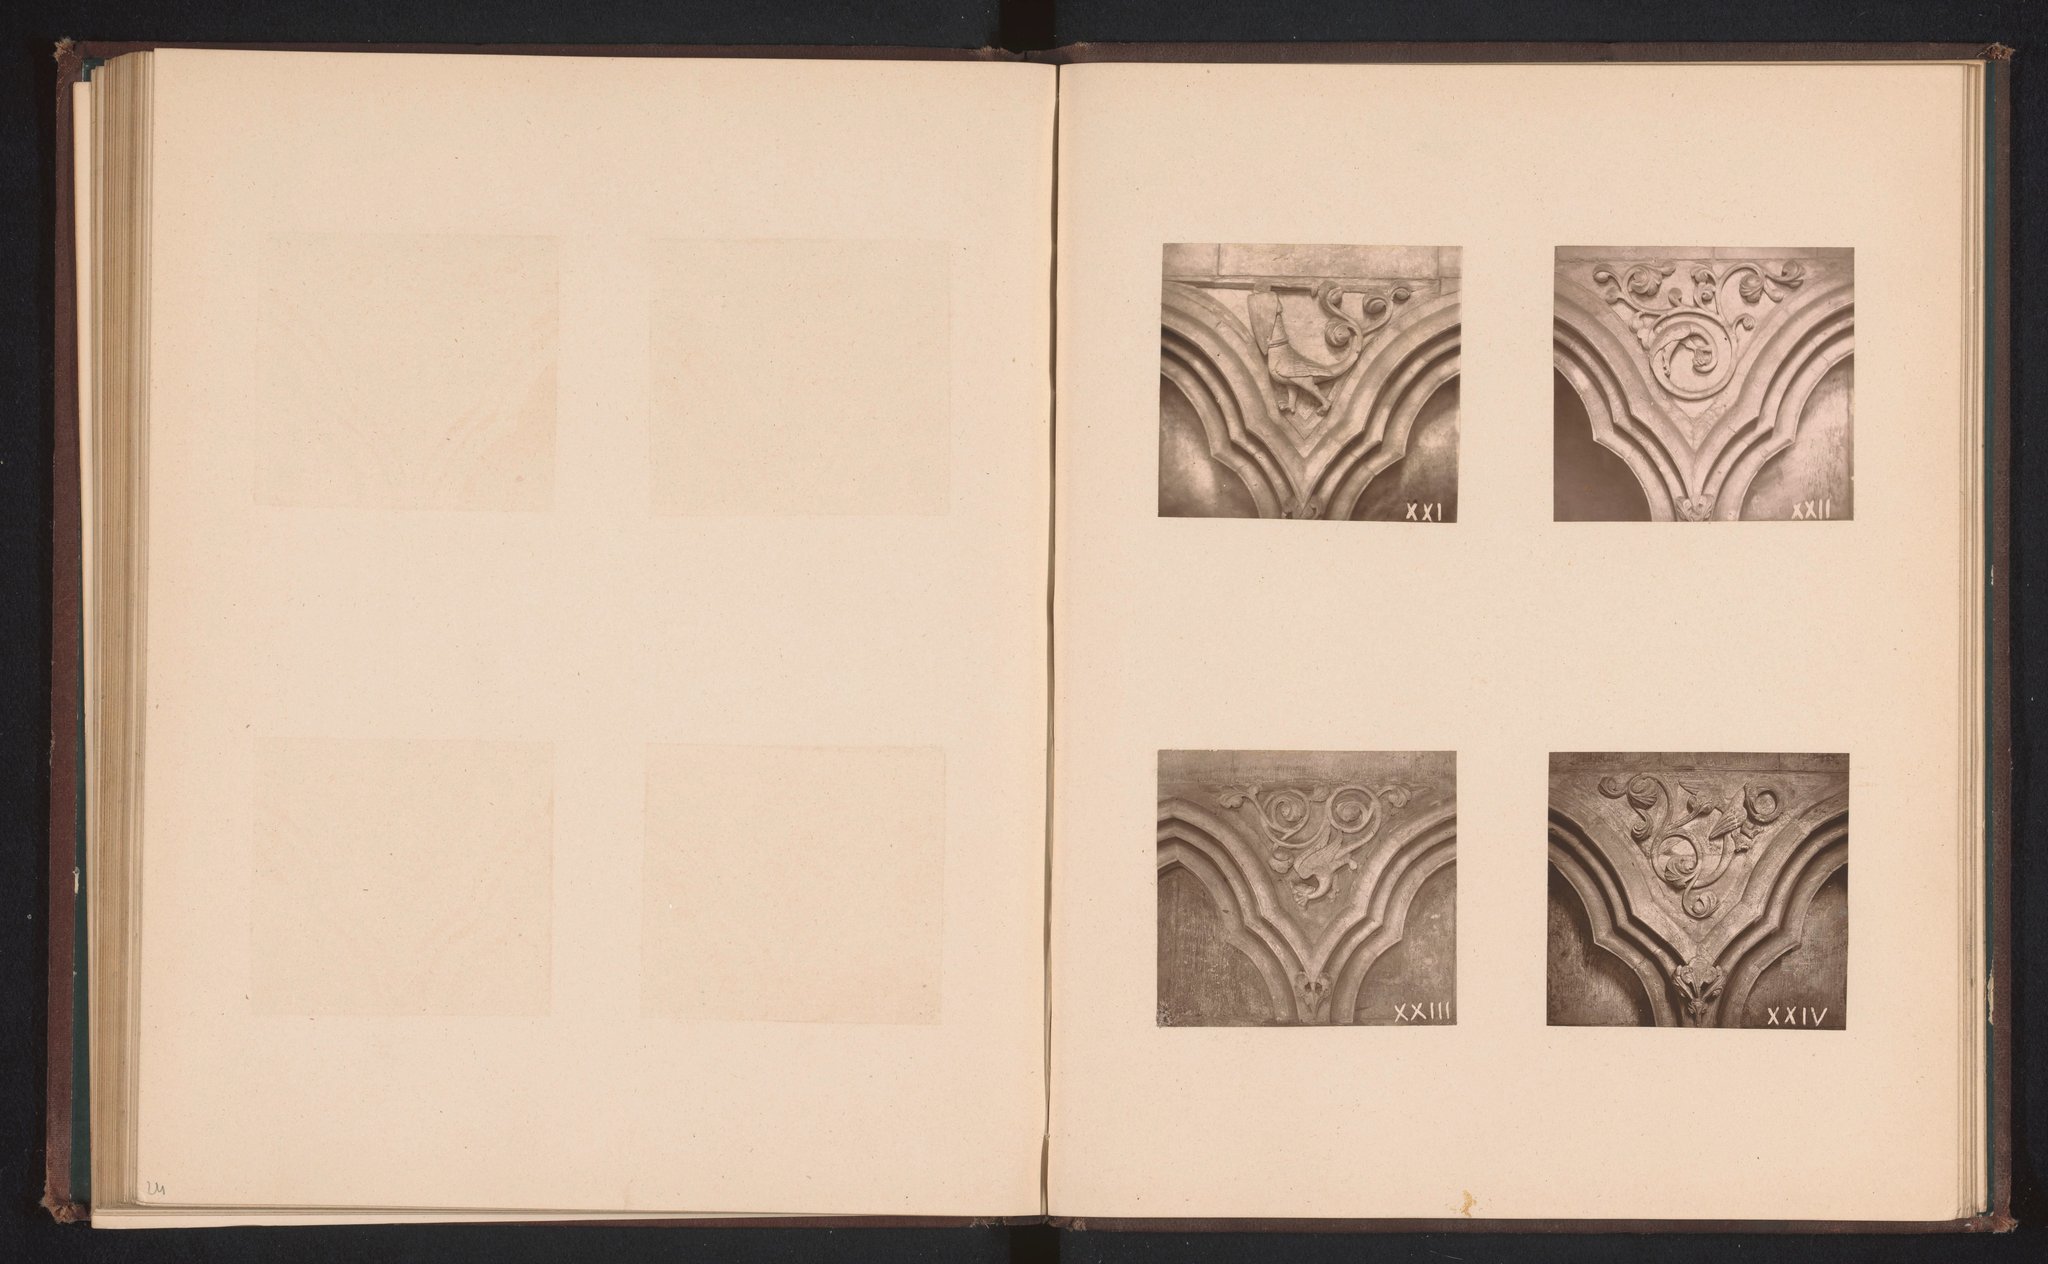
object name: photomechanical print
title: Vier houtsnijwerken in een arcade van de Kathedraal van Worcester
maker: Anonymous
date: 1863-1873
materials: paper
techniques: woodburytype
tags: carving ~ applied arts, fabulous animals (sometimes wrongly called 'grotesques'); 'mostri' (ripa), interior of church, ornament derived from plant forms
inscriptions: number: ‘XXI (...) XXIV’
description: Linksboven een fabelwezen, rechtsboven, linksonder en rechtsonder een plantmotief.